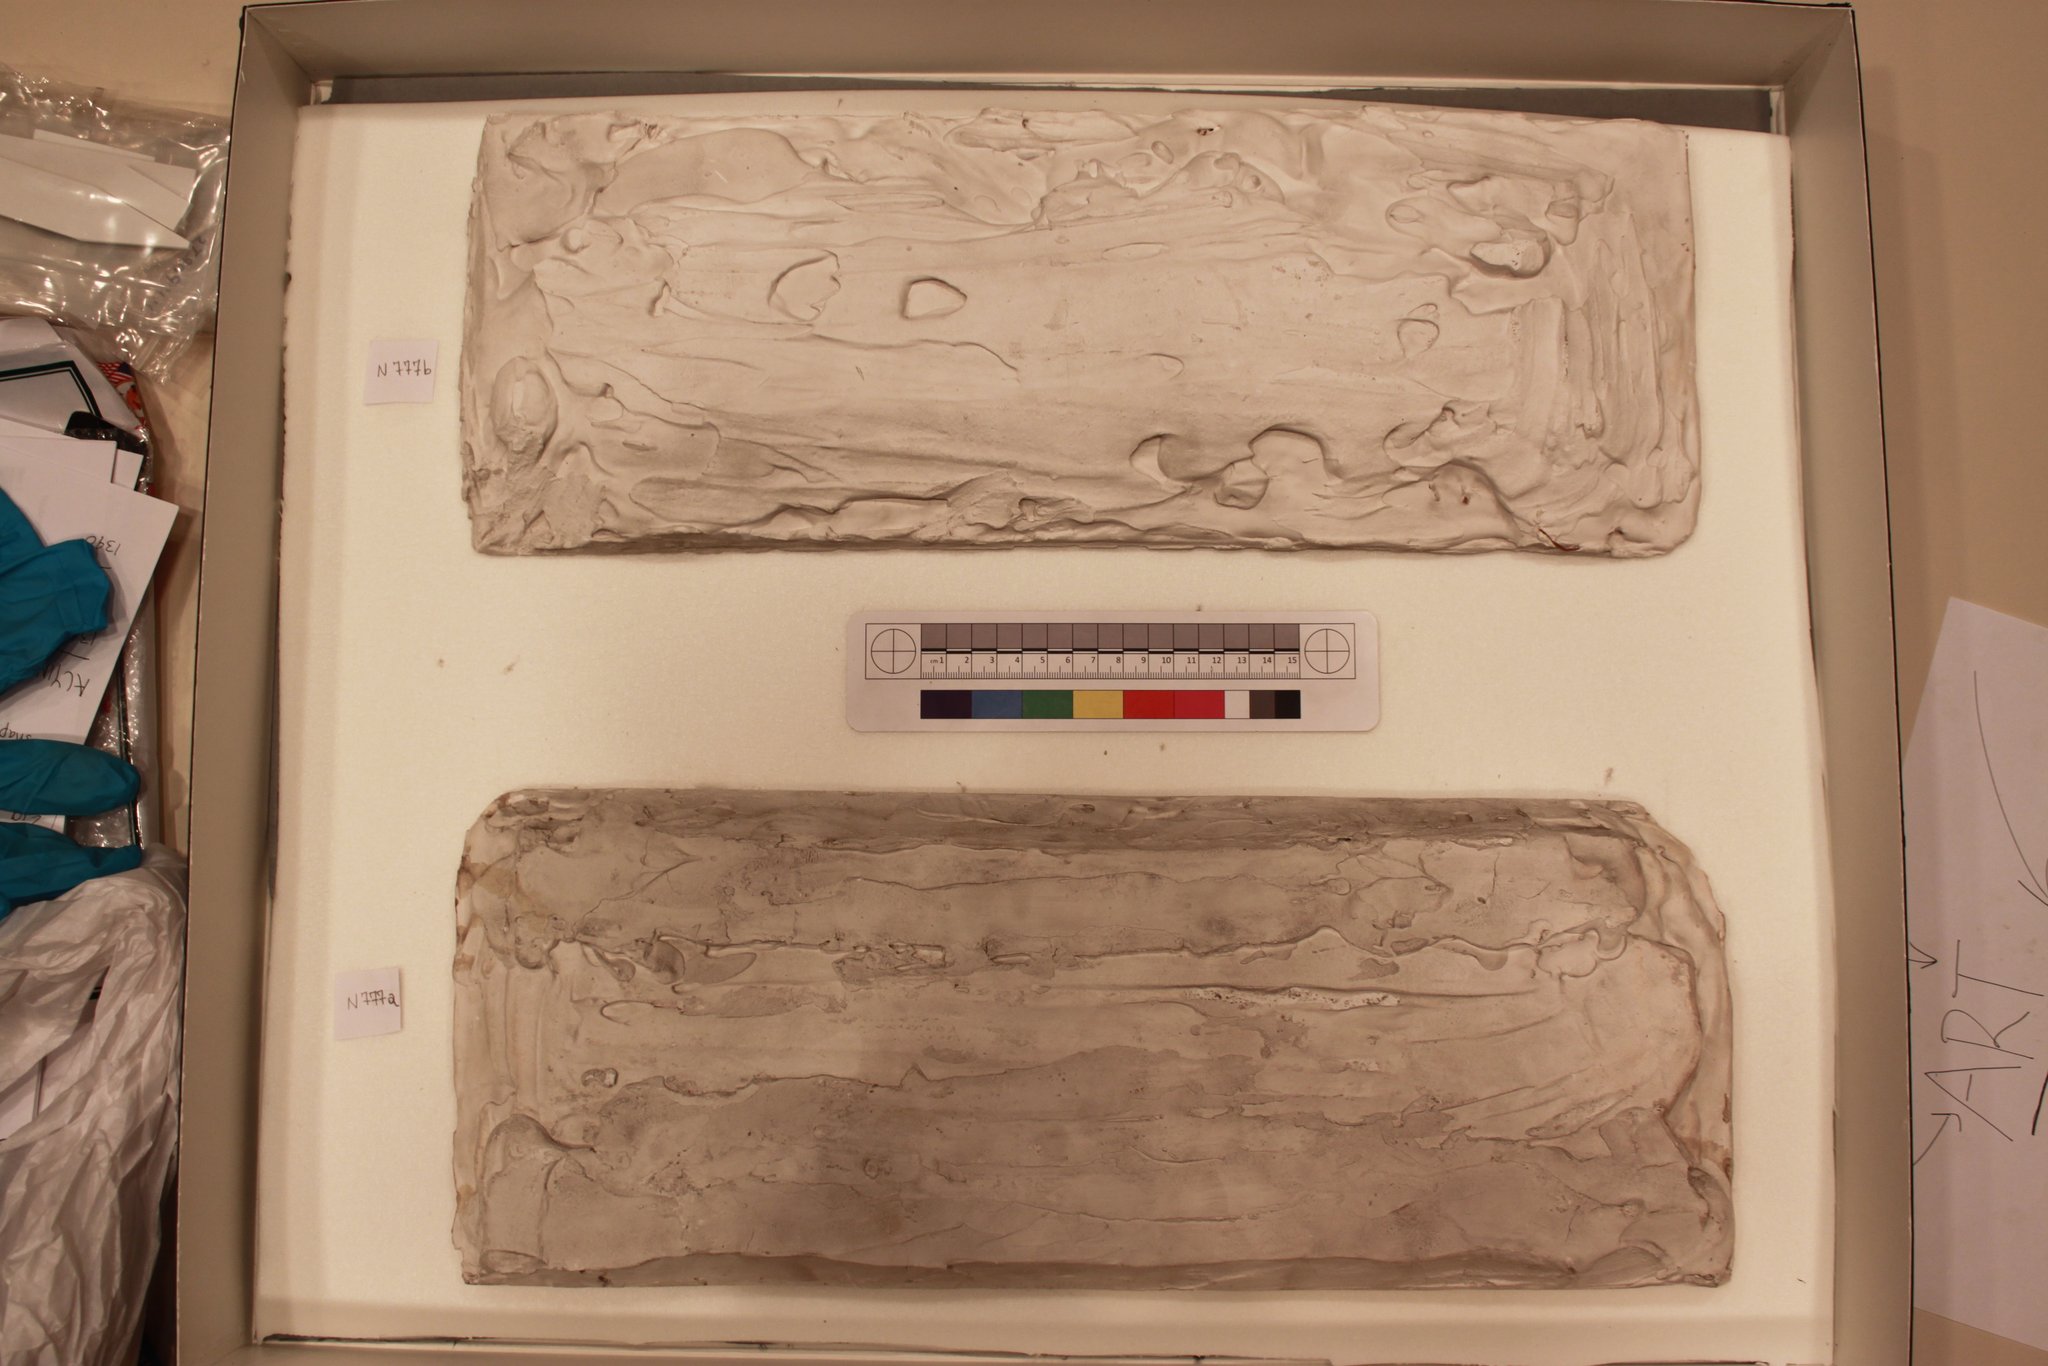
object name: fragment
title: Stucco Fragment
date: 701-1200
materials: gypsum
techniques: carving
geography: iran